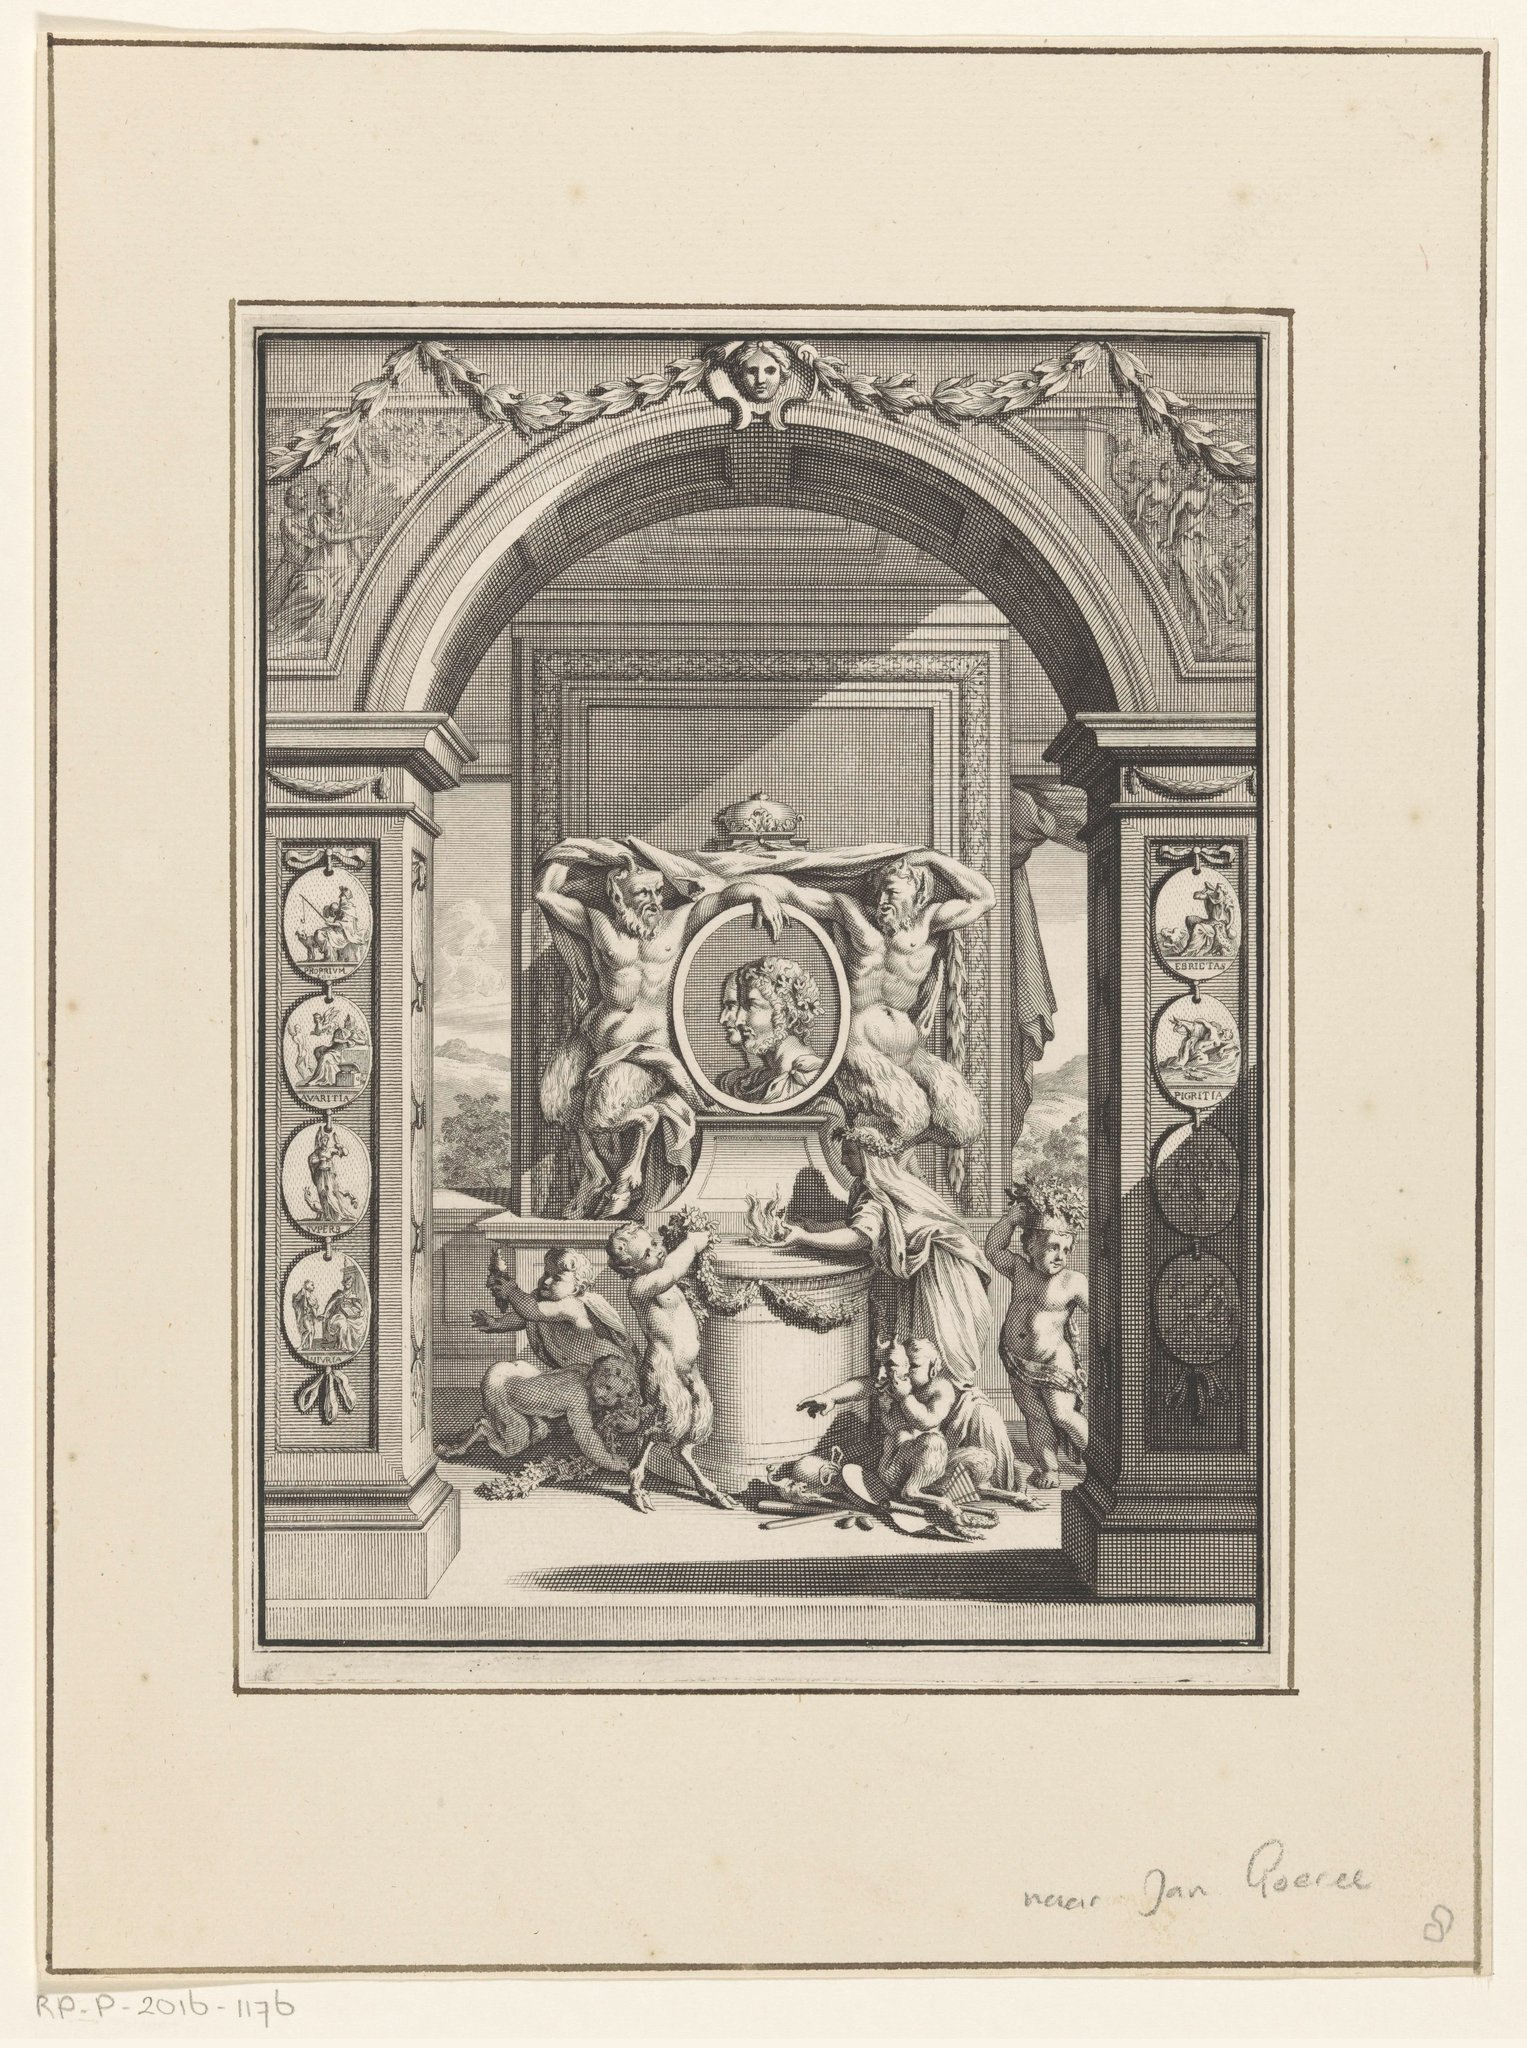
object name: print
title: Allegorische voorstelling met saters bij portretmedaillon en altaar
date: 1700-1799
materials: paper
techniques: engraving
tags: ornament ~ medallion, satyr(s) (in general), altar, cupids: 'amores', 'amoretti', 'putti'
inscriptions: collector's mark: Lugt 240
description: Twee saters dragen een doek boven hun hoofd en flankeren een medaillon met dubbelportret. Daarvoor staat een vrouw met bloemenkrans bij een brandend altaar. Putti met bokkenpoten met maskers, guirlandes en bloemenmand omringen haar. Op de voorgrond een rondboog met medaillons onder andere van zondes.